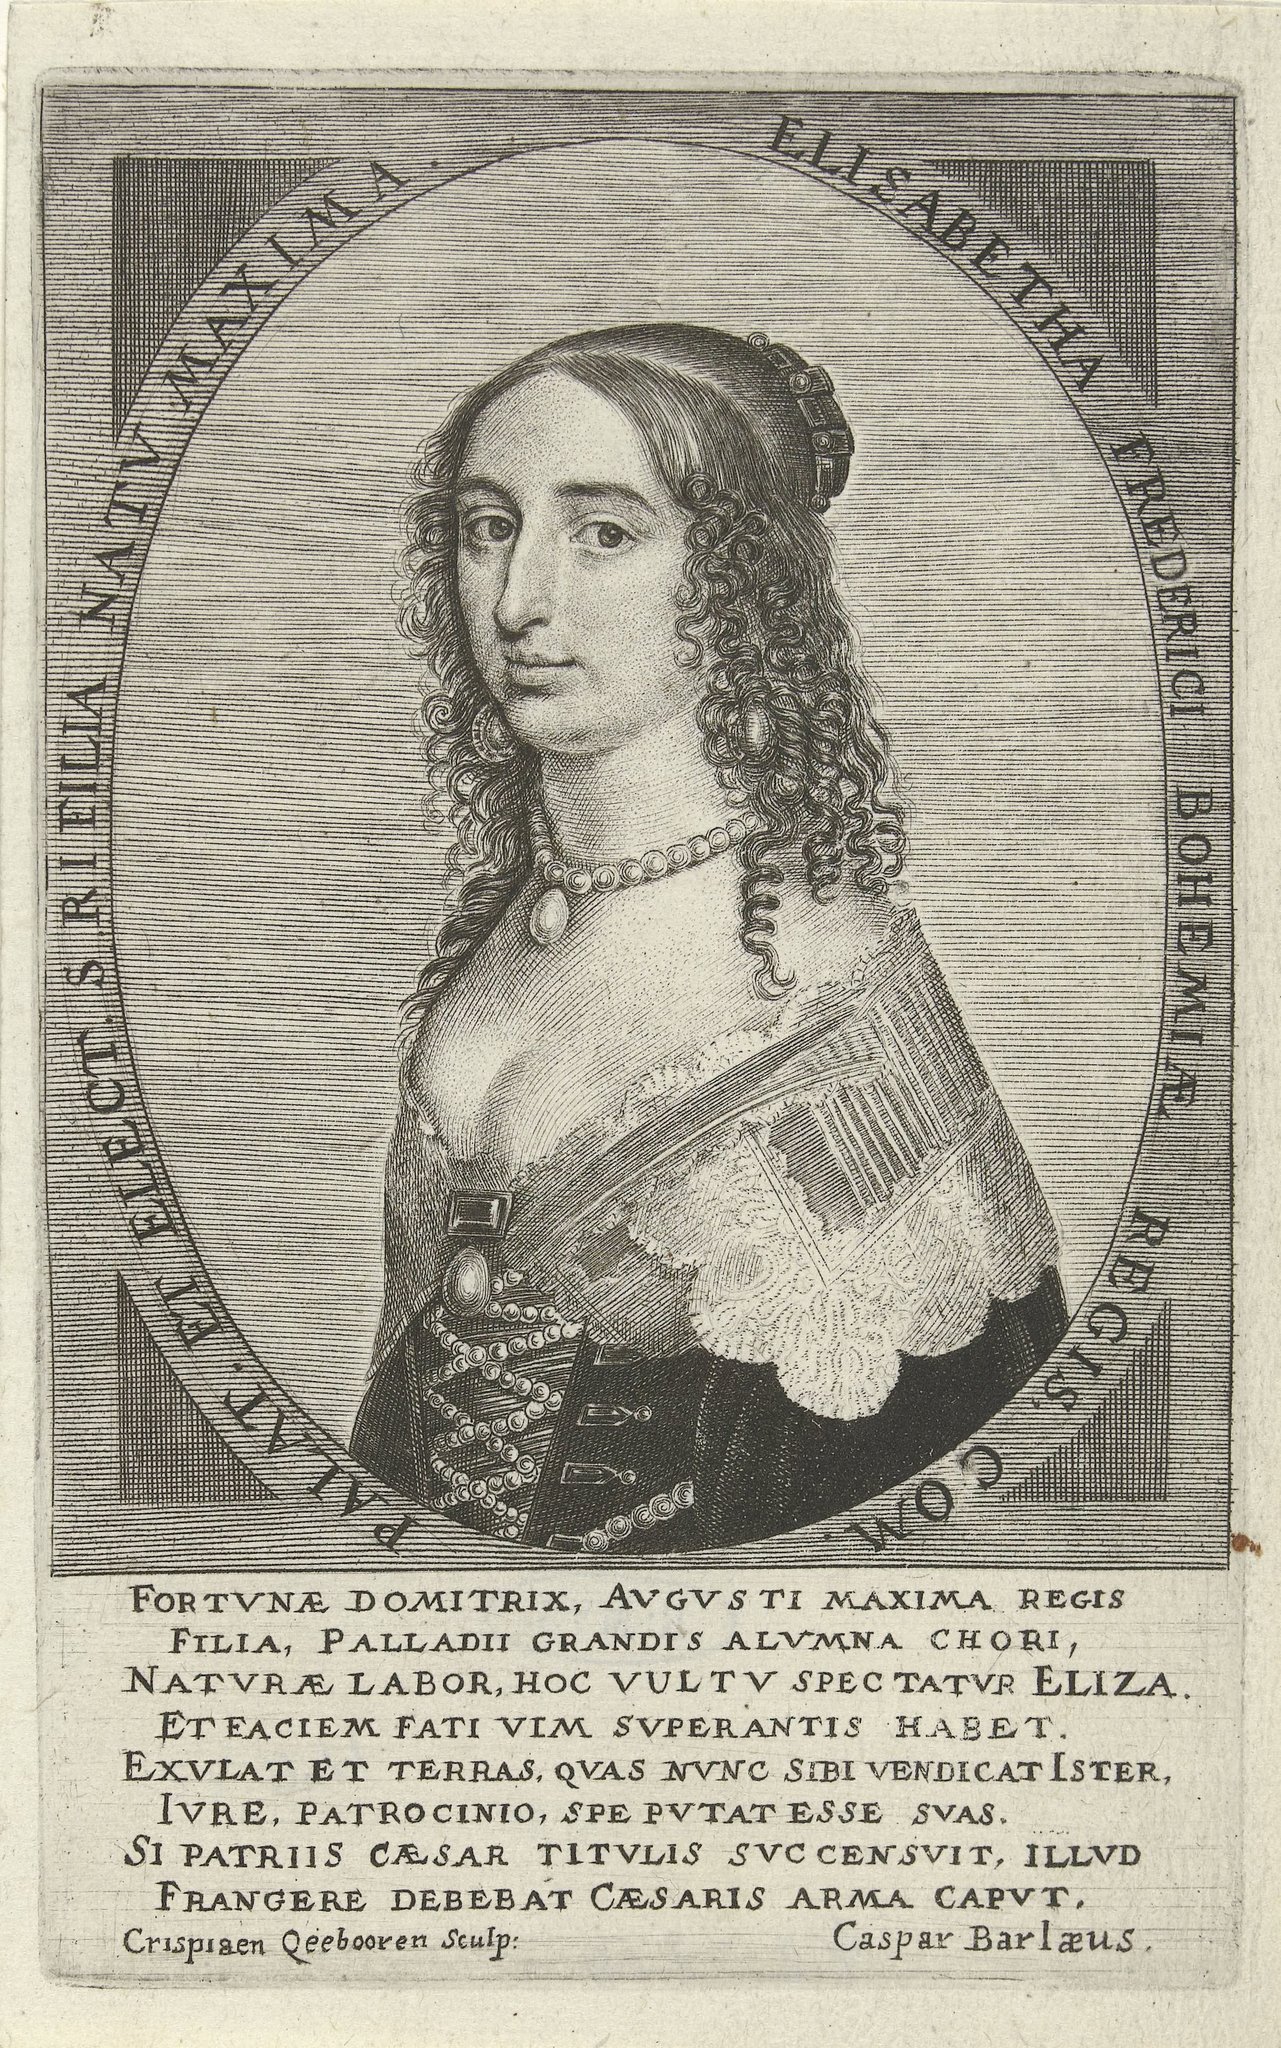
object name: print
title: Portret van Elisabeth van Bohemen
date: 1633-1652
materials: paper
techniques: engraving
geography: the hague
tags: heidelberg, prinses, elisabeth van de palts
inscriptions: collector's mark: Lugt 2760, collector's mark: Lugt 2228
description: Portret van Elisabeth van Bohemen, dochter van Frederik V, koning van Bohemen (bijgenaamd de 'Winterkoning') en Elizabeth Stuart. Elisabeth van Bohemen correspondeerde met René Descartes en Anna Maria van Schurman.